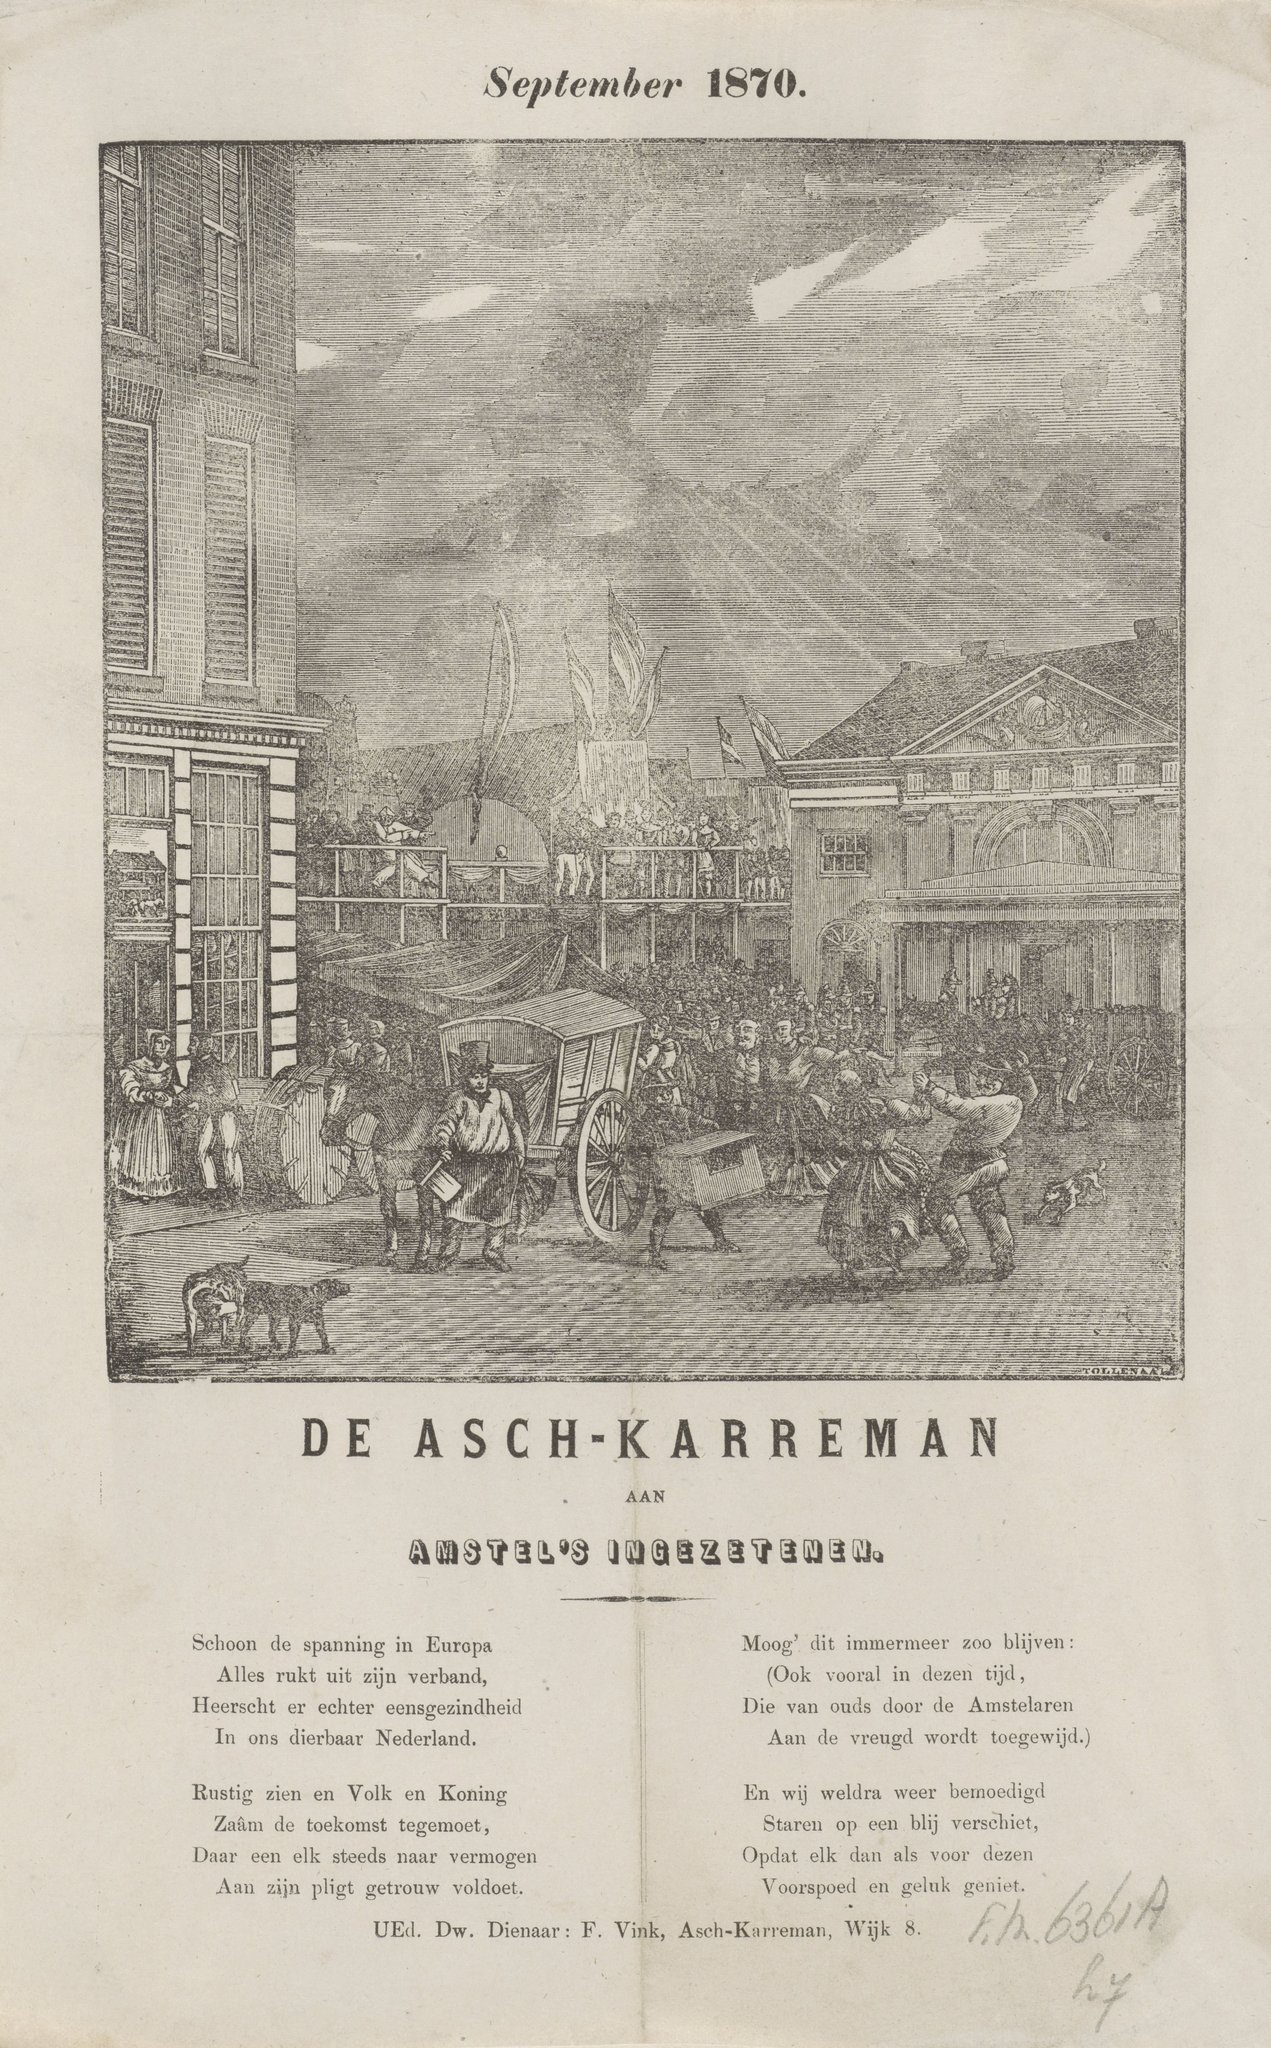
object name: fair print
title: Kermisprent van de Amsterdamse askarrenmannen voor het jaar 1870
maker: dirk wijbrand tollenaar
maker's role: print maker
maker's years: 1808-1858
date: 1870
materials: paper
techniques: letterpress printing, engraving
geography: amsterdam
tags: public road - ii - ideal city, pleasure fair and circus, garbage collection, amsterdam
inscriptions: collector's mark: Lugt 2228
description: Kermisprent namens de askarrenmannen (karrenman of vuilnisman) te Amsterdam, september 1870. Gezicht op de kermis op de Botermarkt met de Regulierswaag. Op de markt twee vuilniskarren. Onderaan een gedicht in twee kolommen. Namens F. Vink, de askarreman van wijk no. 8.